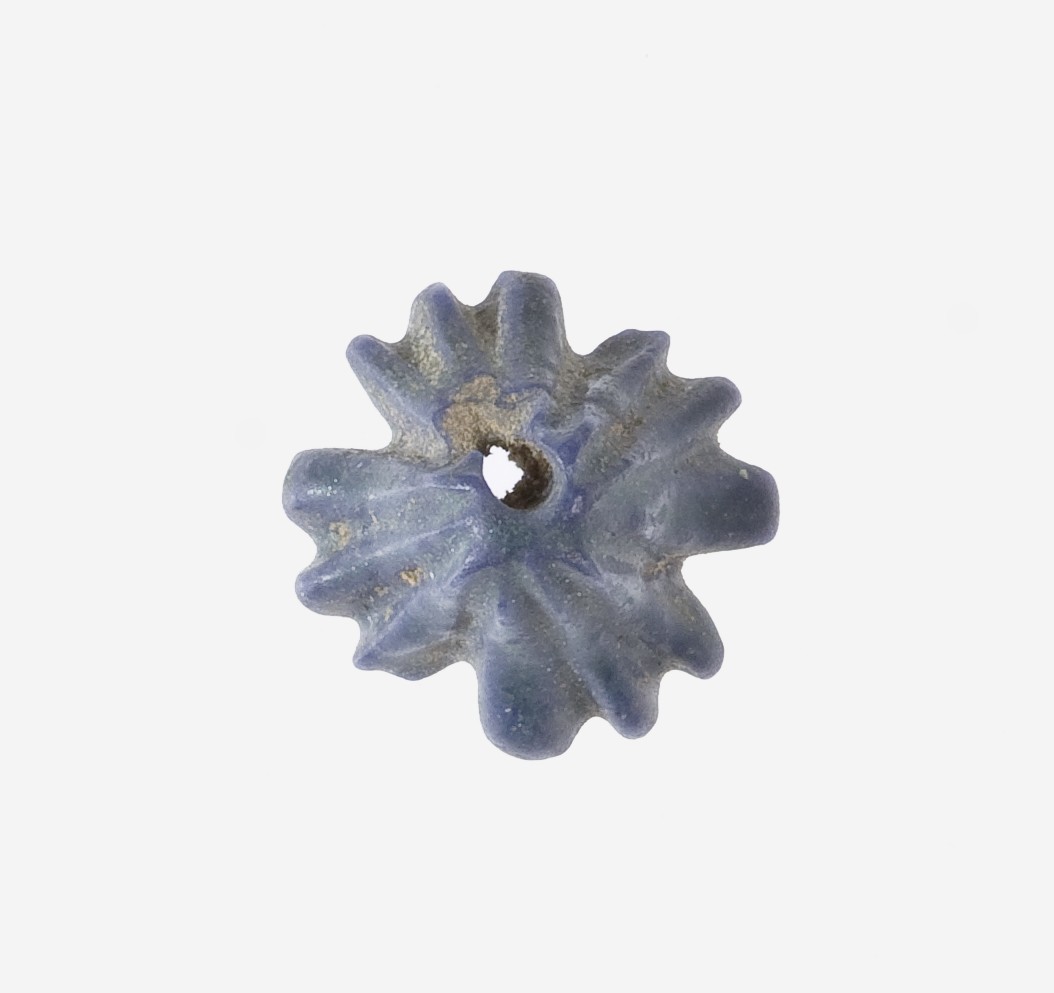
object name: pendant, cornflower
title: Pendant: Petals of Cornflower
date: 1390-1352 BCE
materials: faience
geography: egypt